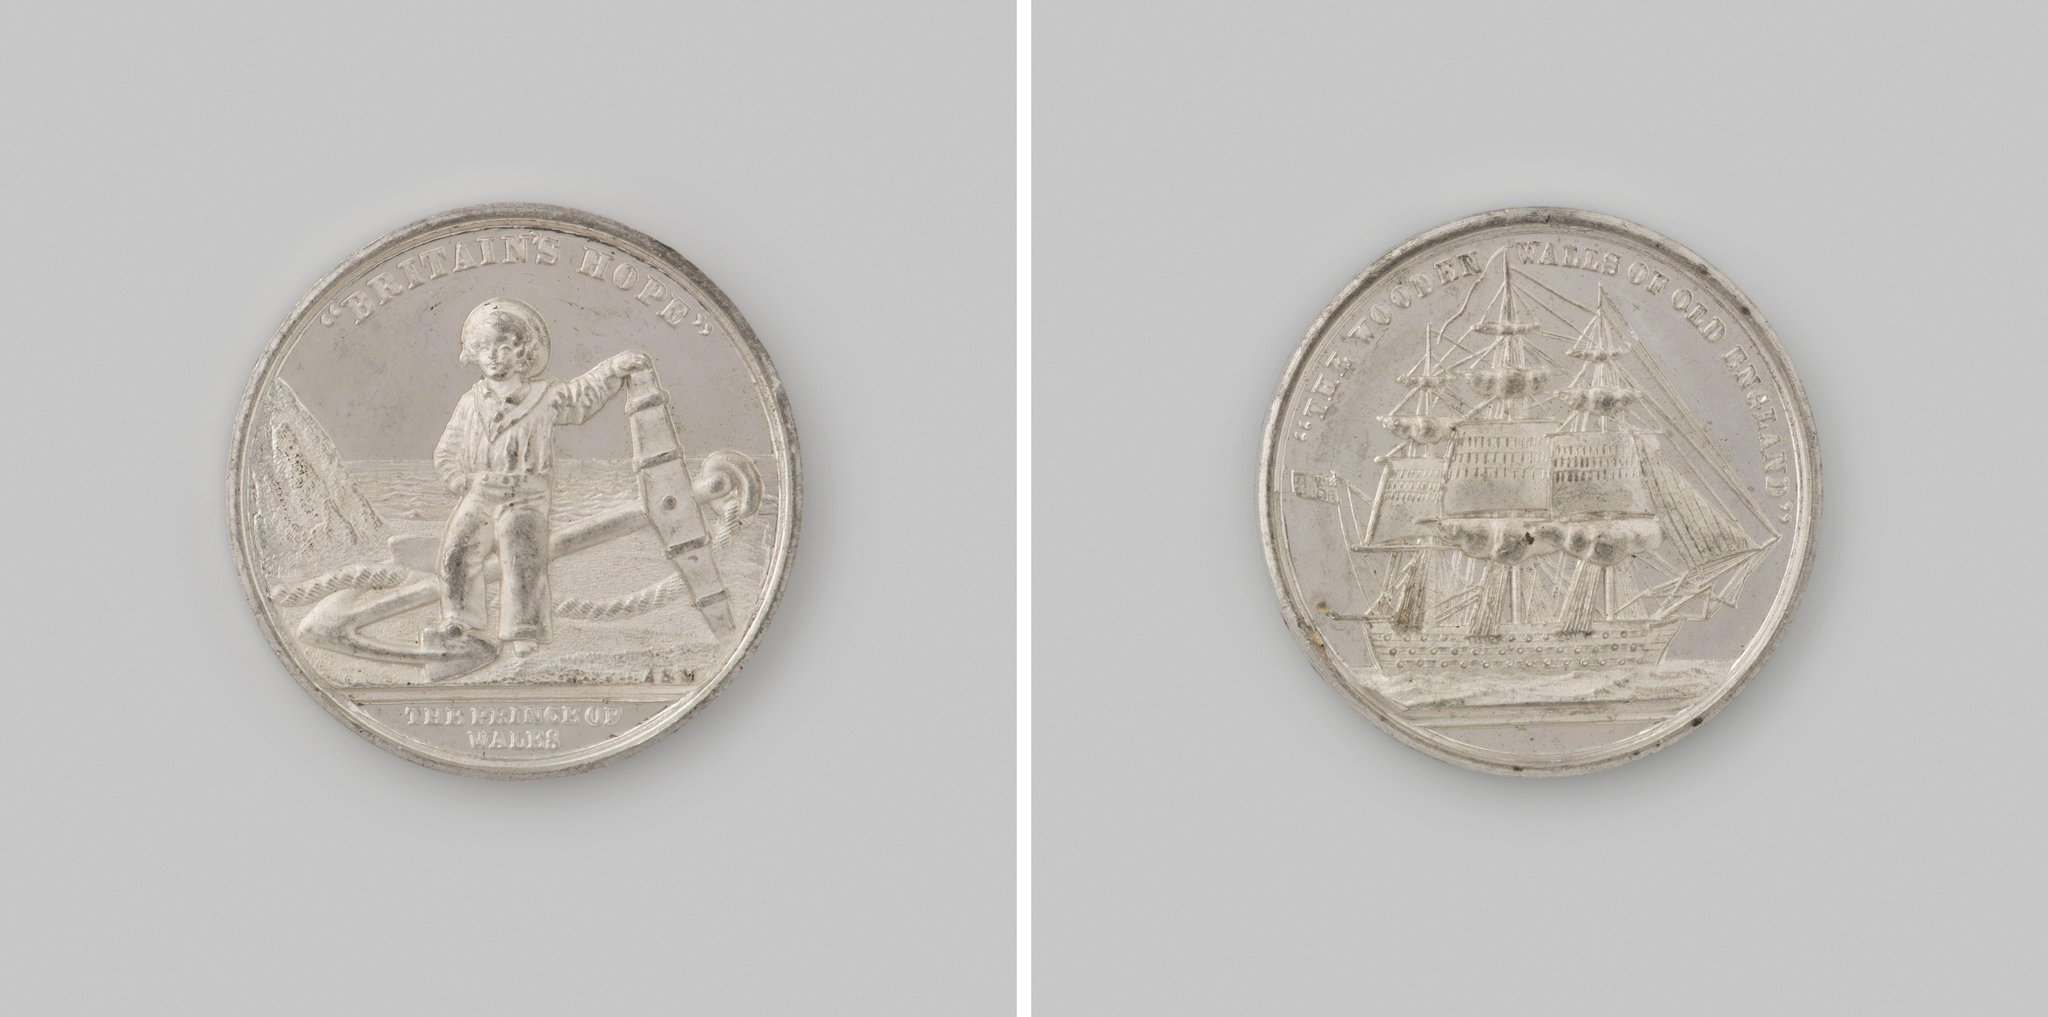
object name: history medal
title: De Prins van Wales en de Britse oorlogsvloot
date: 1850-1870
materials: tin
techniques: striking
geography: birmingham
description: Tinnen penning, op de voorzijde een jongen in matrozenpak met anker bij een rots aan de zee, met omschrift en afsnedetekst, op de keerzijde een zeilschip op zee naar rechts met omschrift.